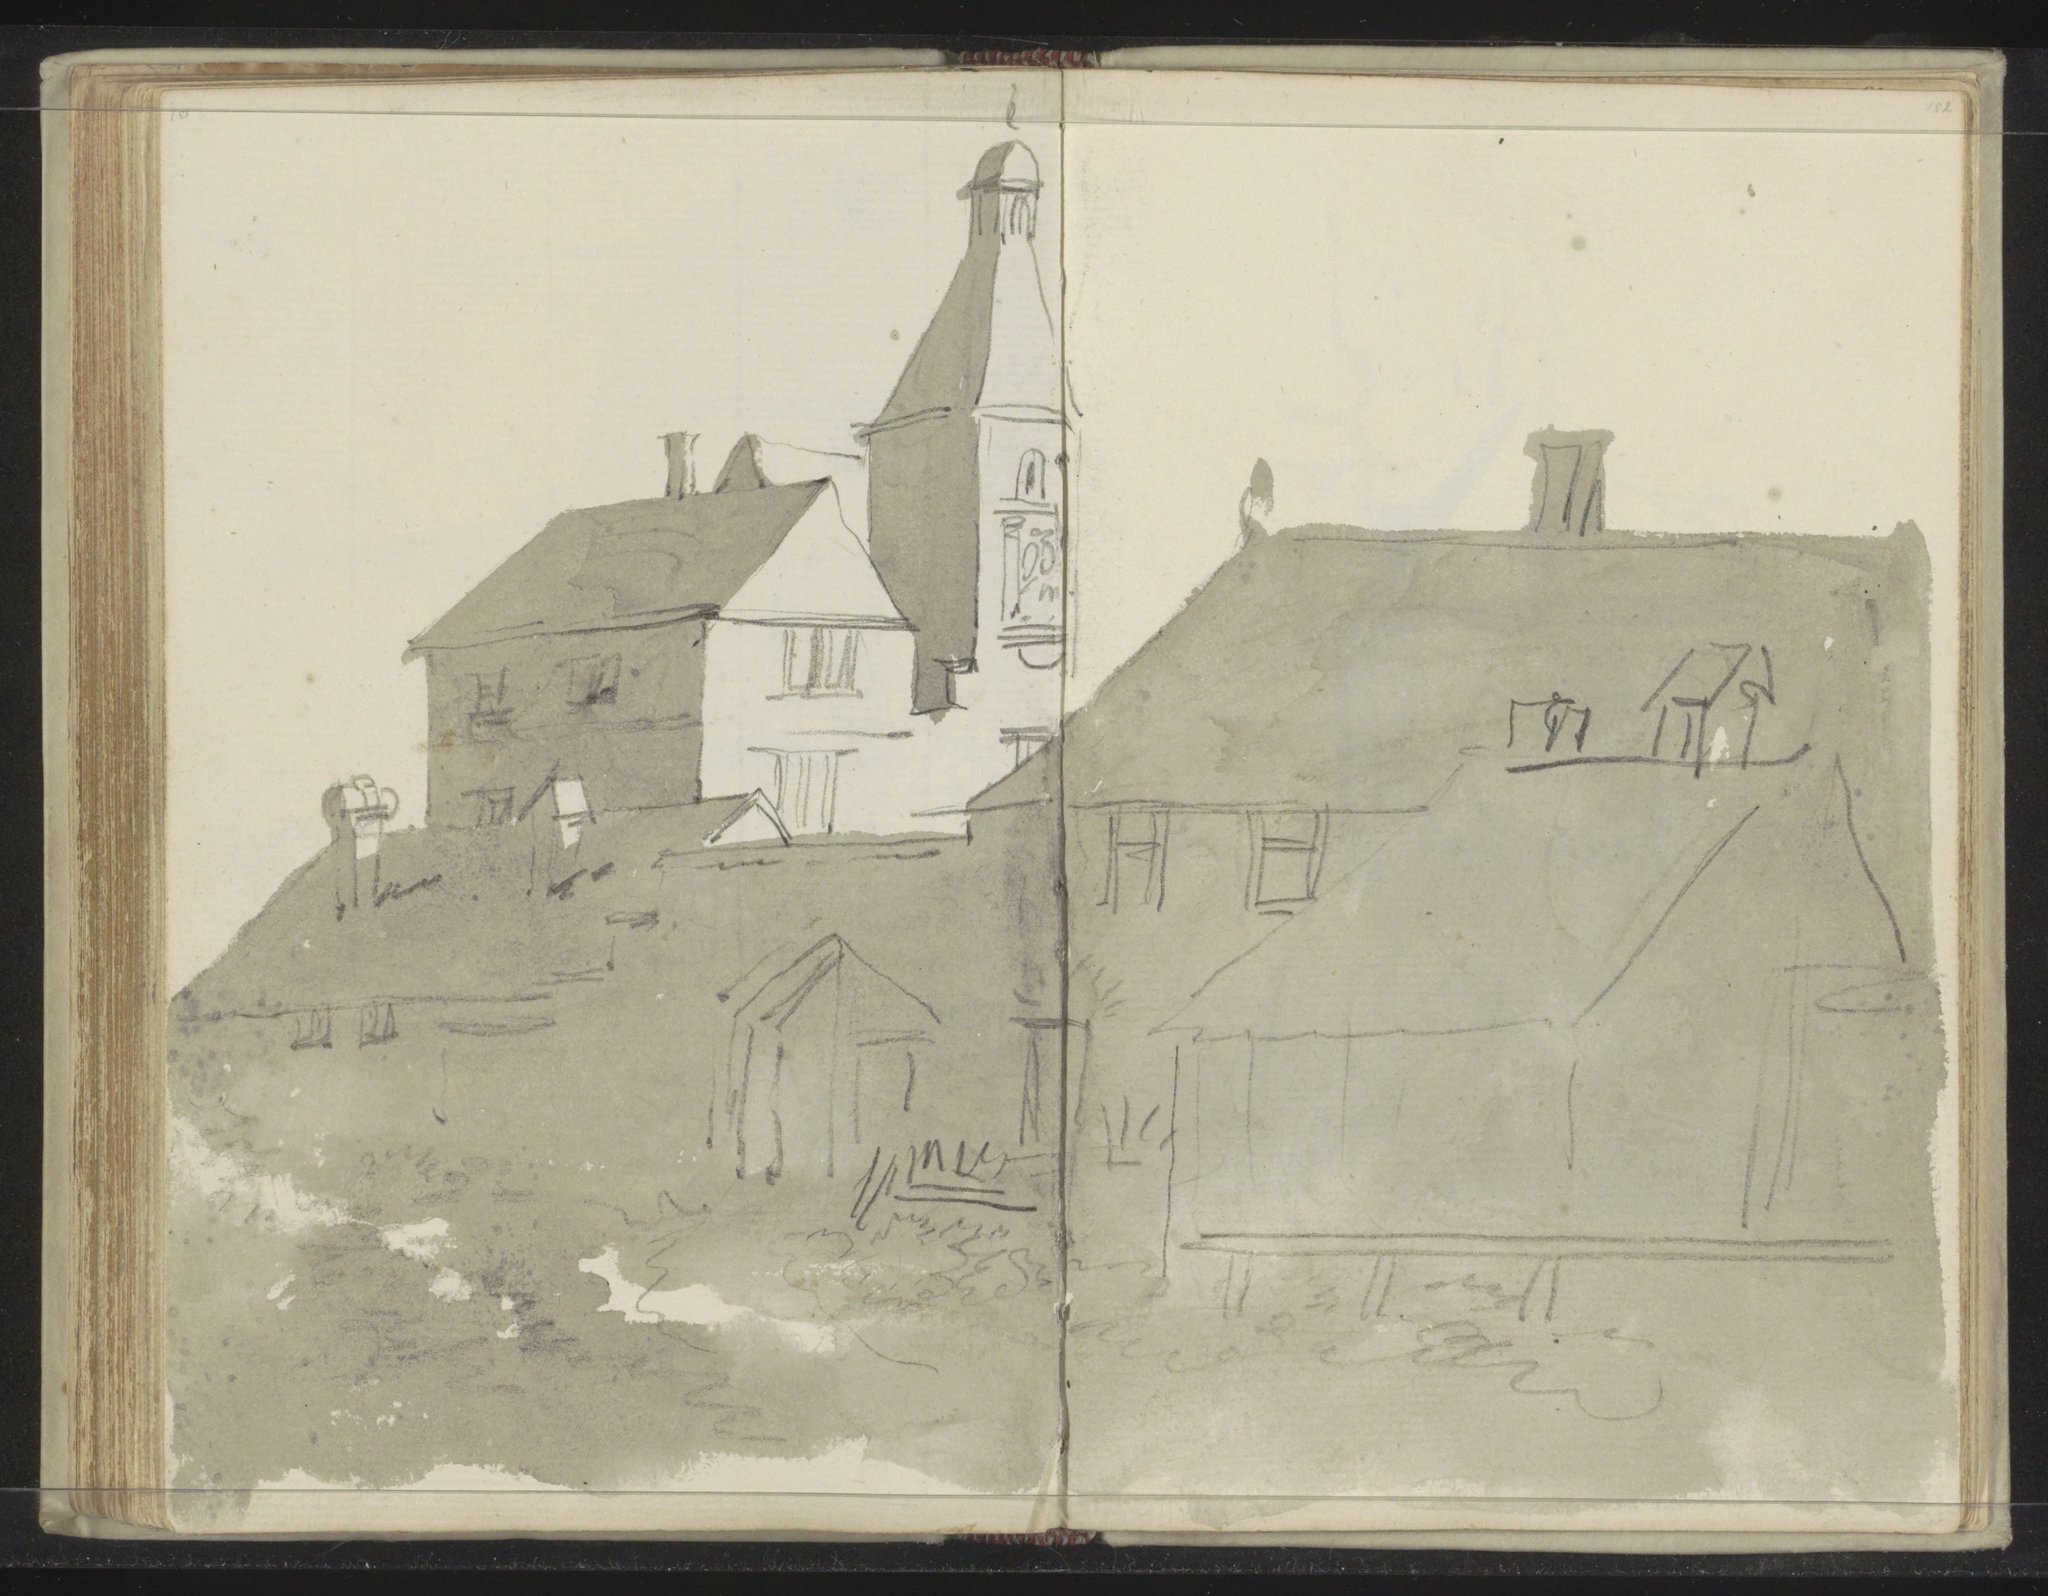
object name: sketchbook leaf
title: Gebouw met een toren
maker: johannes huibert prins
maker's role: draughtsman, painter, print maker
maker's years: 1757-1806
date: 1783-1797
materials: paper, pencil, watercolor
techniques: brush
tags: exterior ~ representation of a building, tower (of house or building)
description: Pagina 151 en 152 uit een schetsboek met 175 pagina's.